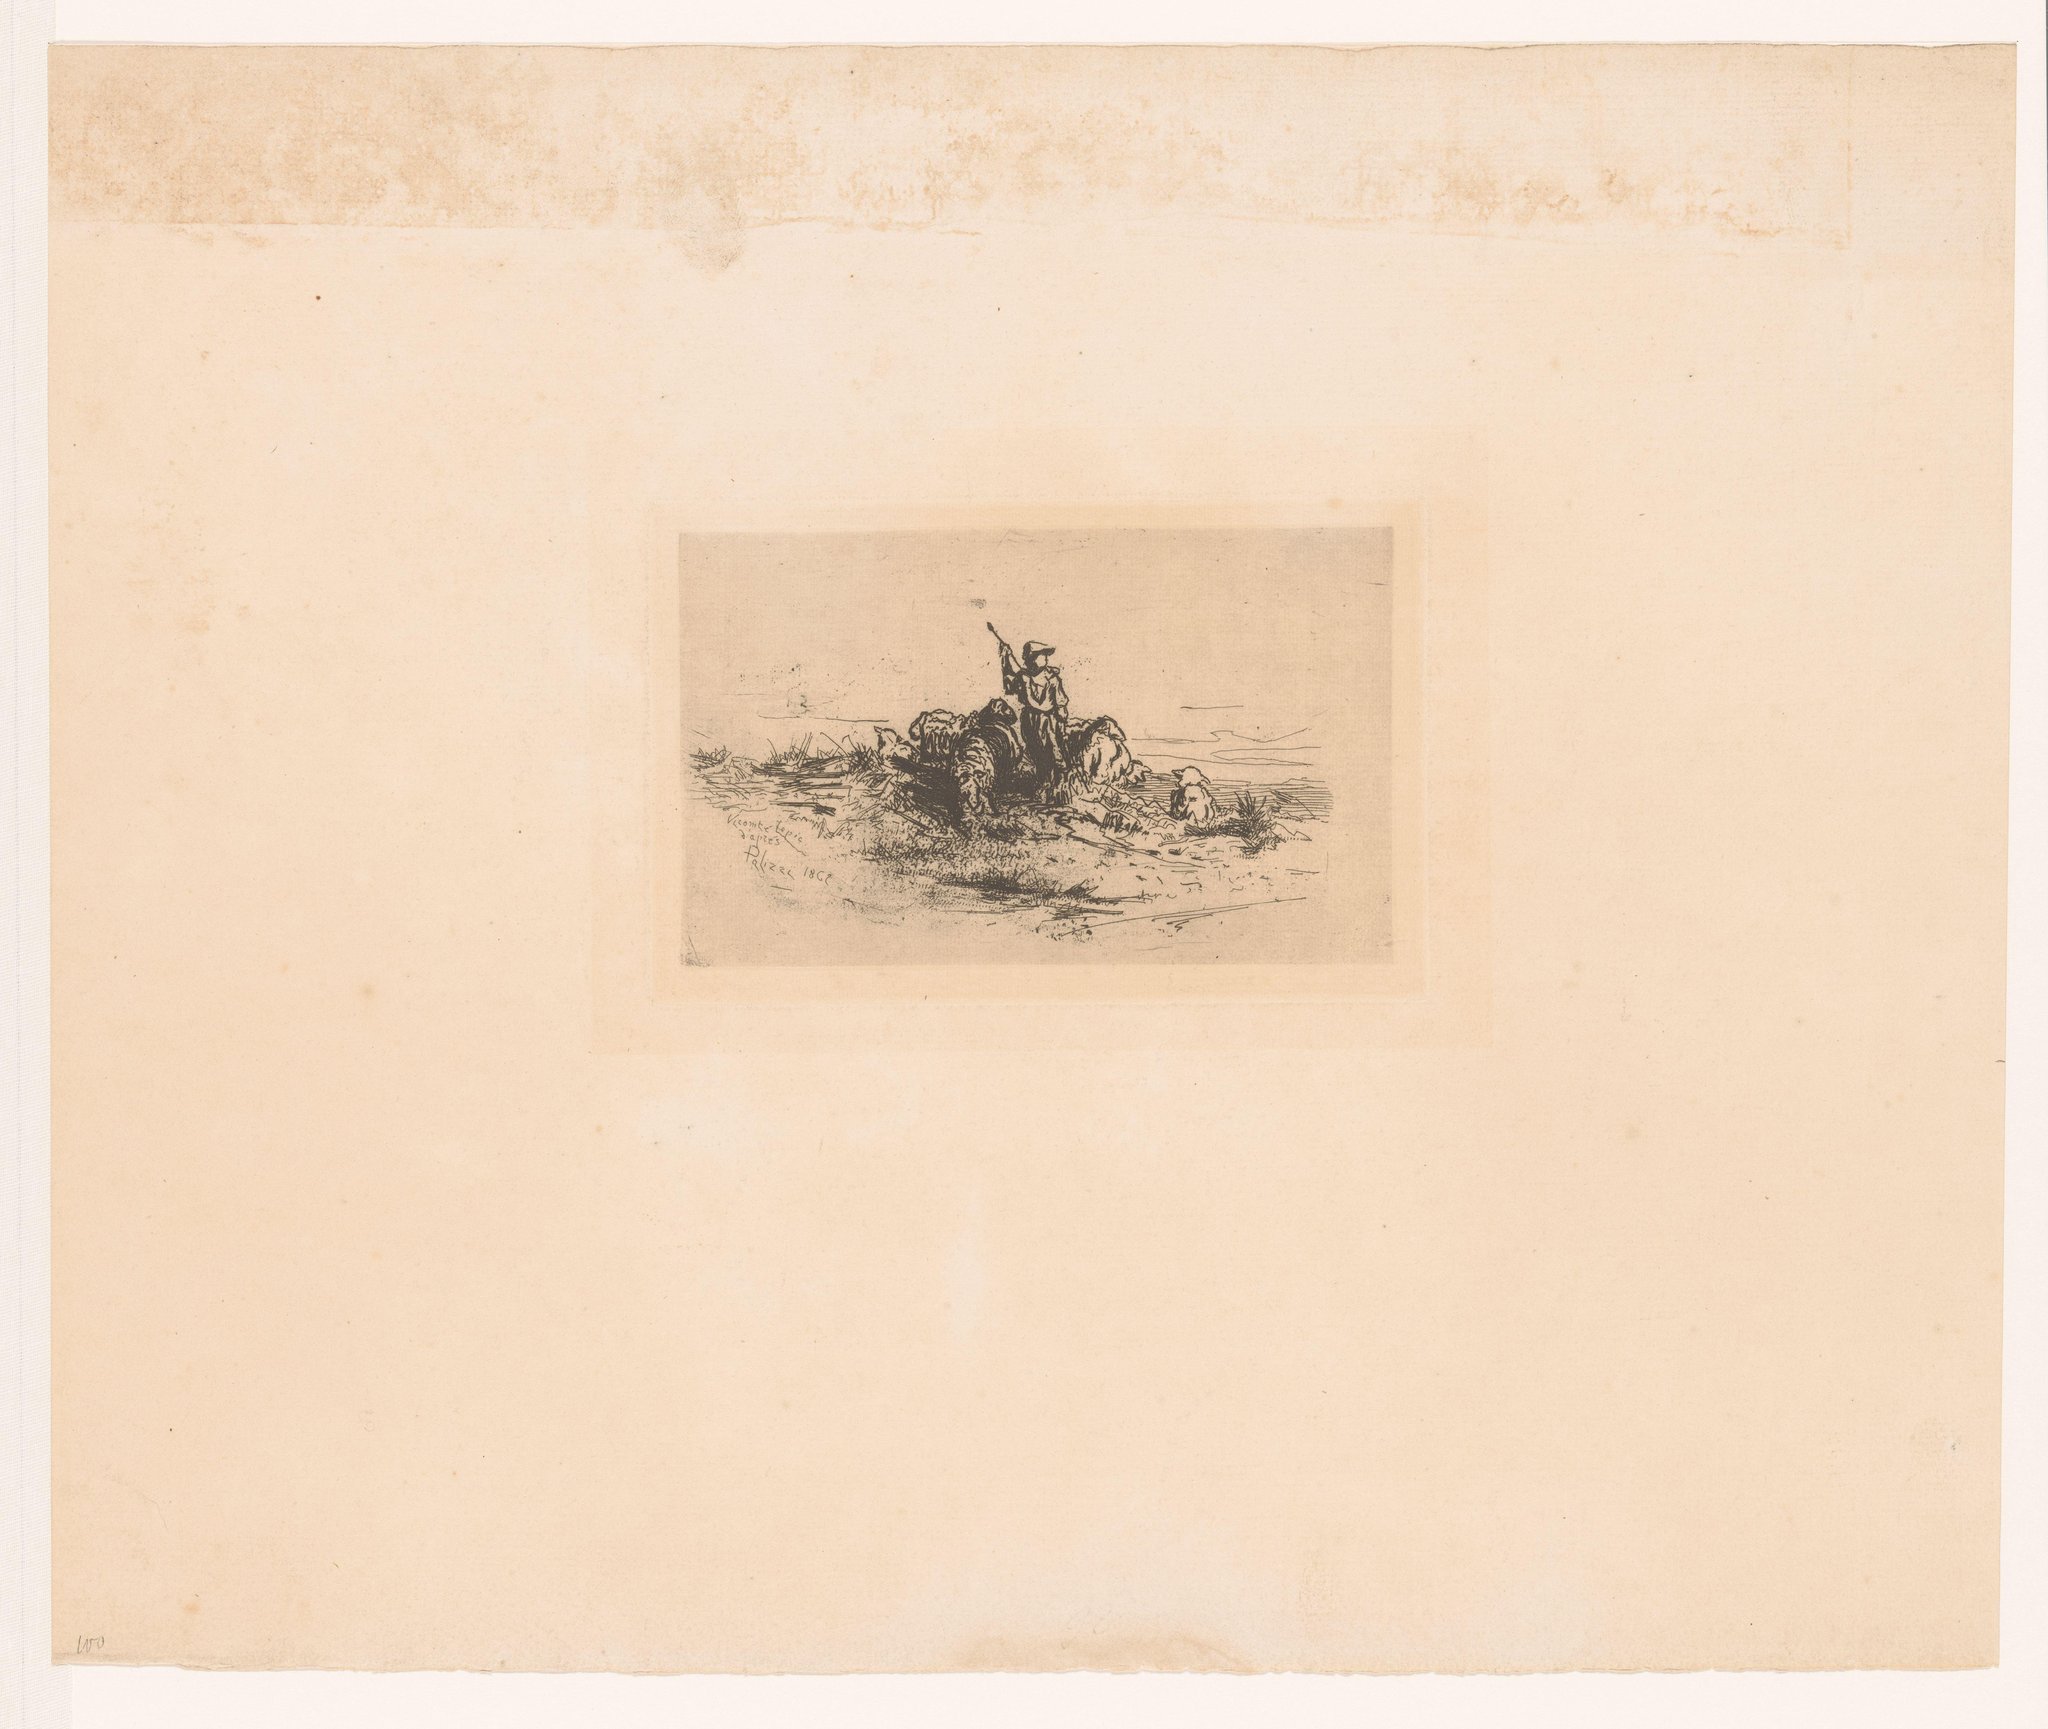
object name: print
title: Schaapherder met kudde op een vlakte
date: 1862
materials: paper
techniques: etching, intaglio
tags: herding, herdsman, herdswoman, shepherd, shepherdess, cowherd, etc., sheep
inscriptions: collector's mark: Lugt 2760, collector's mark: Lugt 2166, collector's mark: Lugt 2228